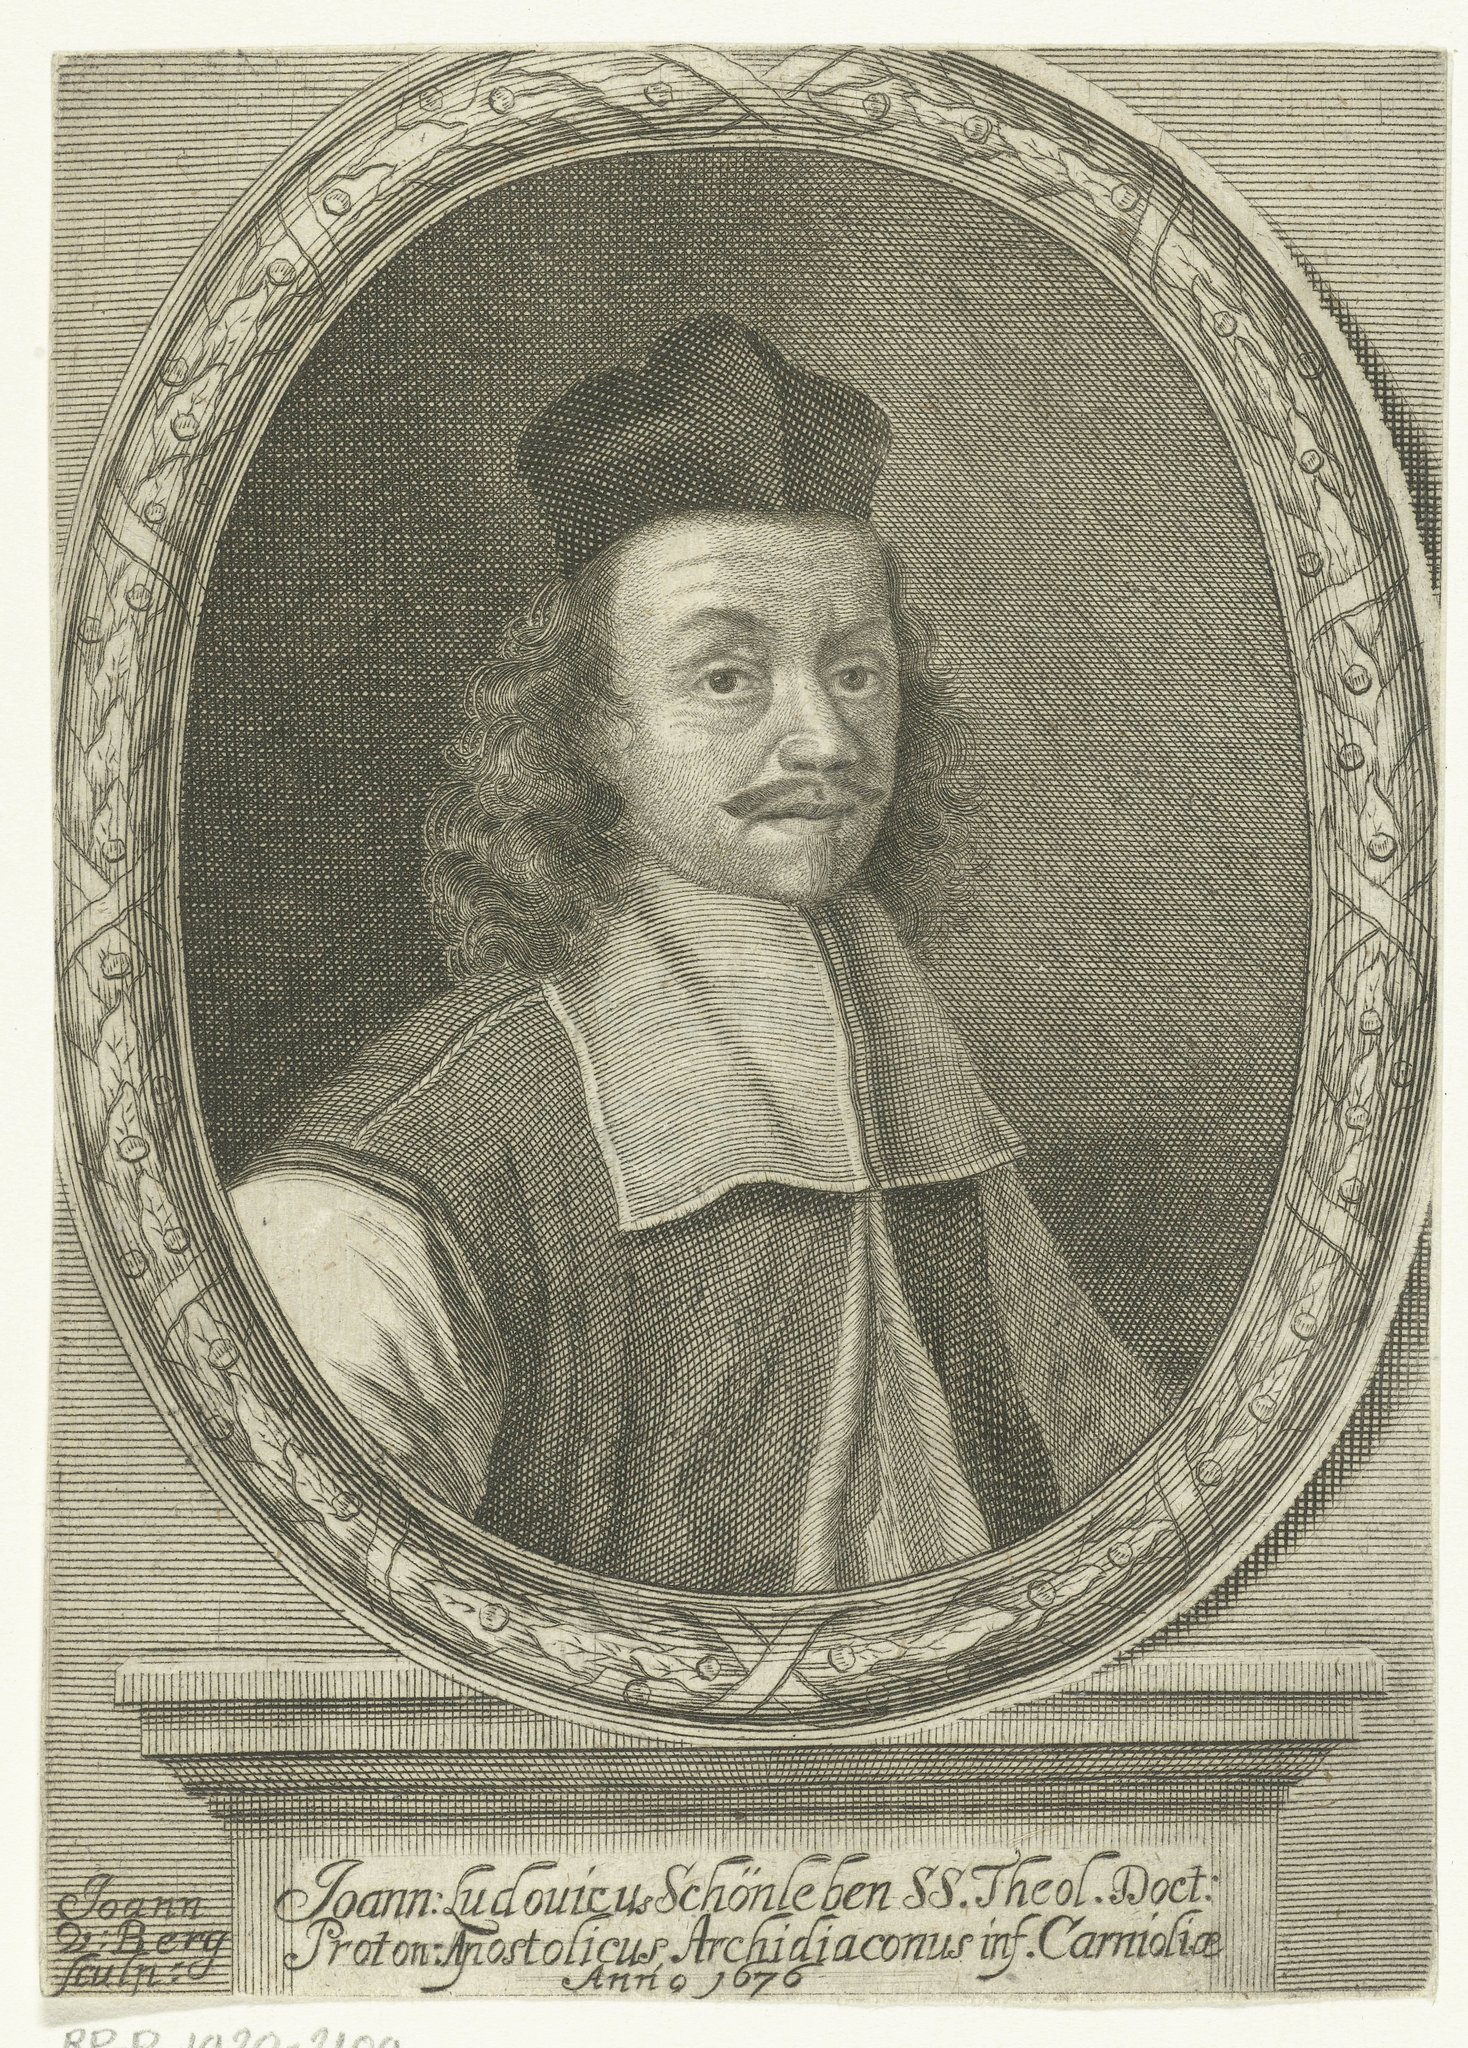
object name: print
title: Portret van aartsdiaken Johann Ludwig Schönleben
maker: joannes van de berg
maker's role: print maker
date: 1676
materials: paper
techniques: engraving, etching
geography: netherlands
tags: laibach, johann ludwig schönleben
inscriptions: collector's mark: Lugt 2228